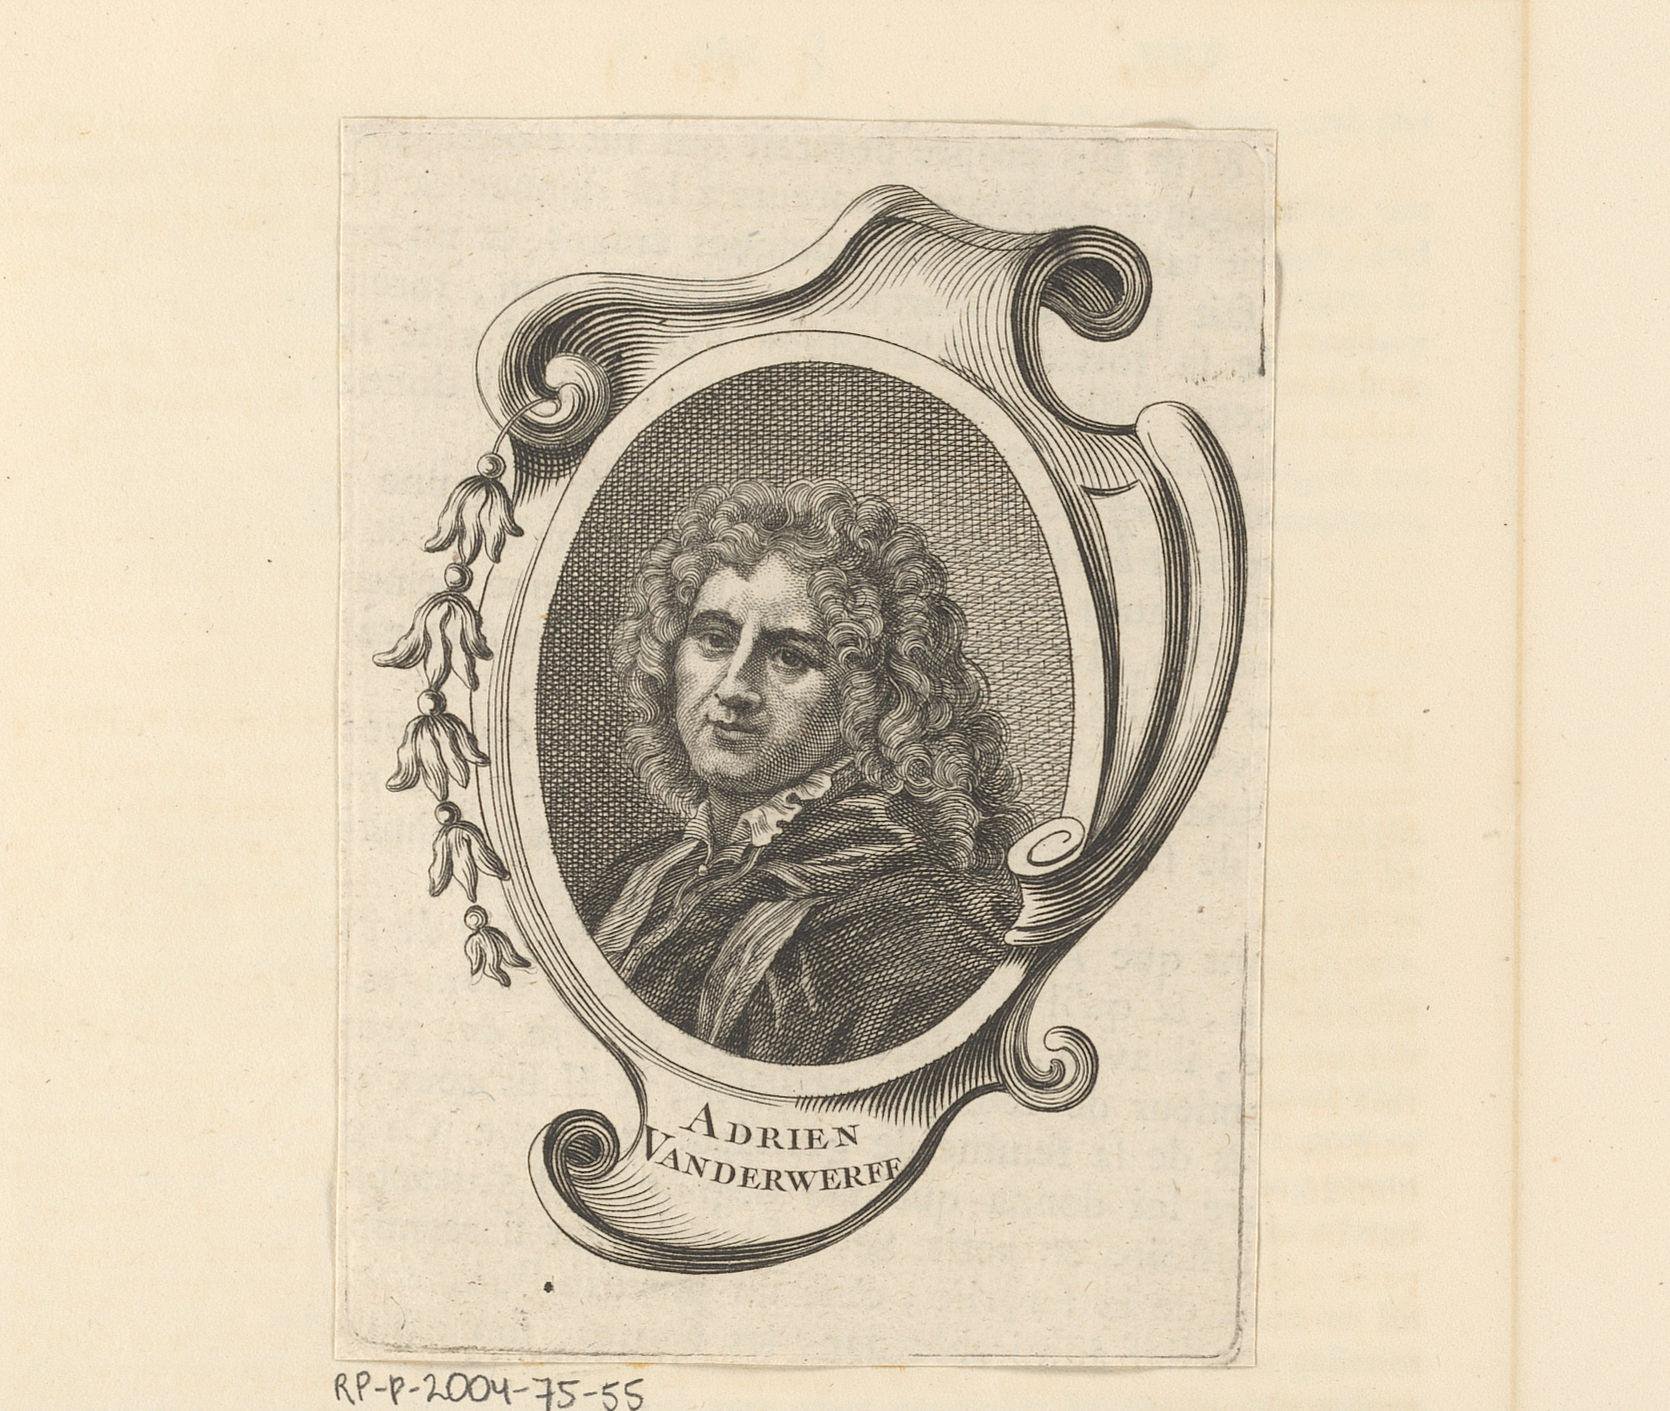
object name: album leaf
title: Andrien Vanderwerff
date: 1745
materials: paper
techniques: engraving, letterpress printing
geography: paris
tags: kralingen-ambacht, rotterdam, painter, print maker, draughtsman, adriaen van der werff, historical persons, portrait, self-portrait of painter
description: Prent uit: Dézallier d'Argenville, Antoine Joseph. Abrégé de la vie des plus fameux peintres. 4 dln. Parijs: De Bure l'aîné, 1745, dl. 2, p. 107. De samensteller heeft deze prent in het album geplakt als illustratie bij: Pilkington, Matthew en Johann Heinrich Füssli. A dictionary of painters, from the revival of the art to the present period. 4 dln. Londen: John Crowder, 1805, dl. 4, p. 643.